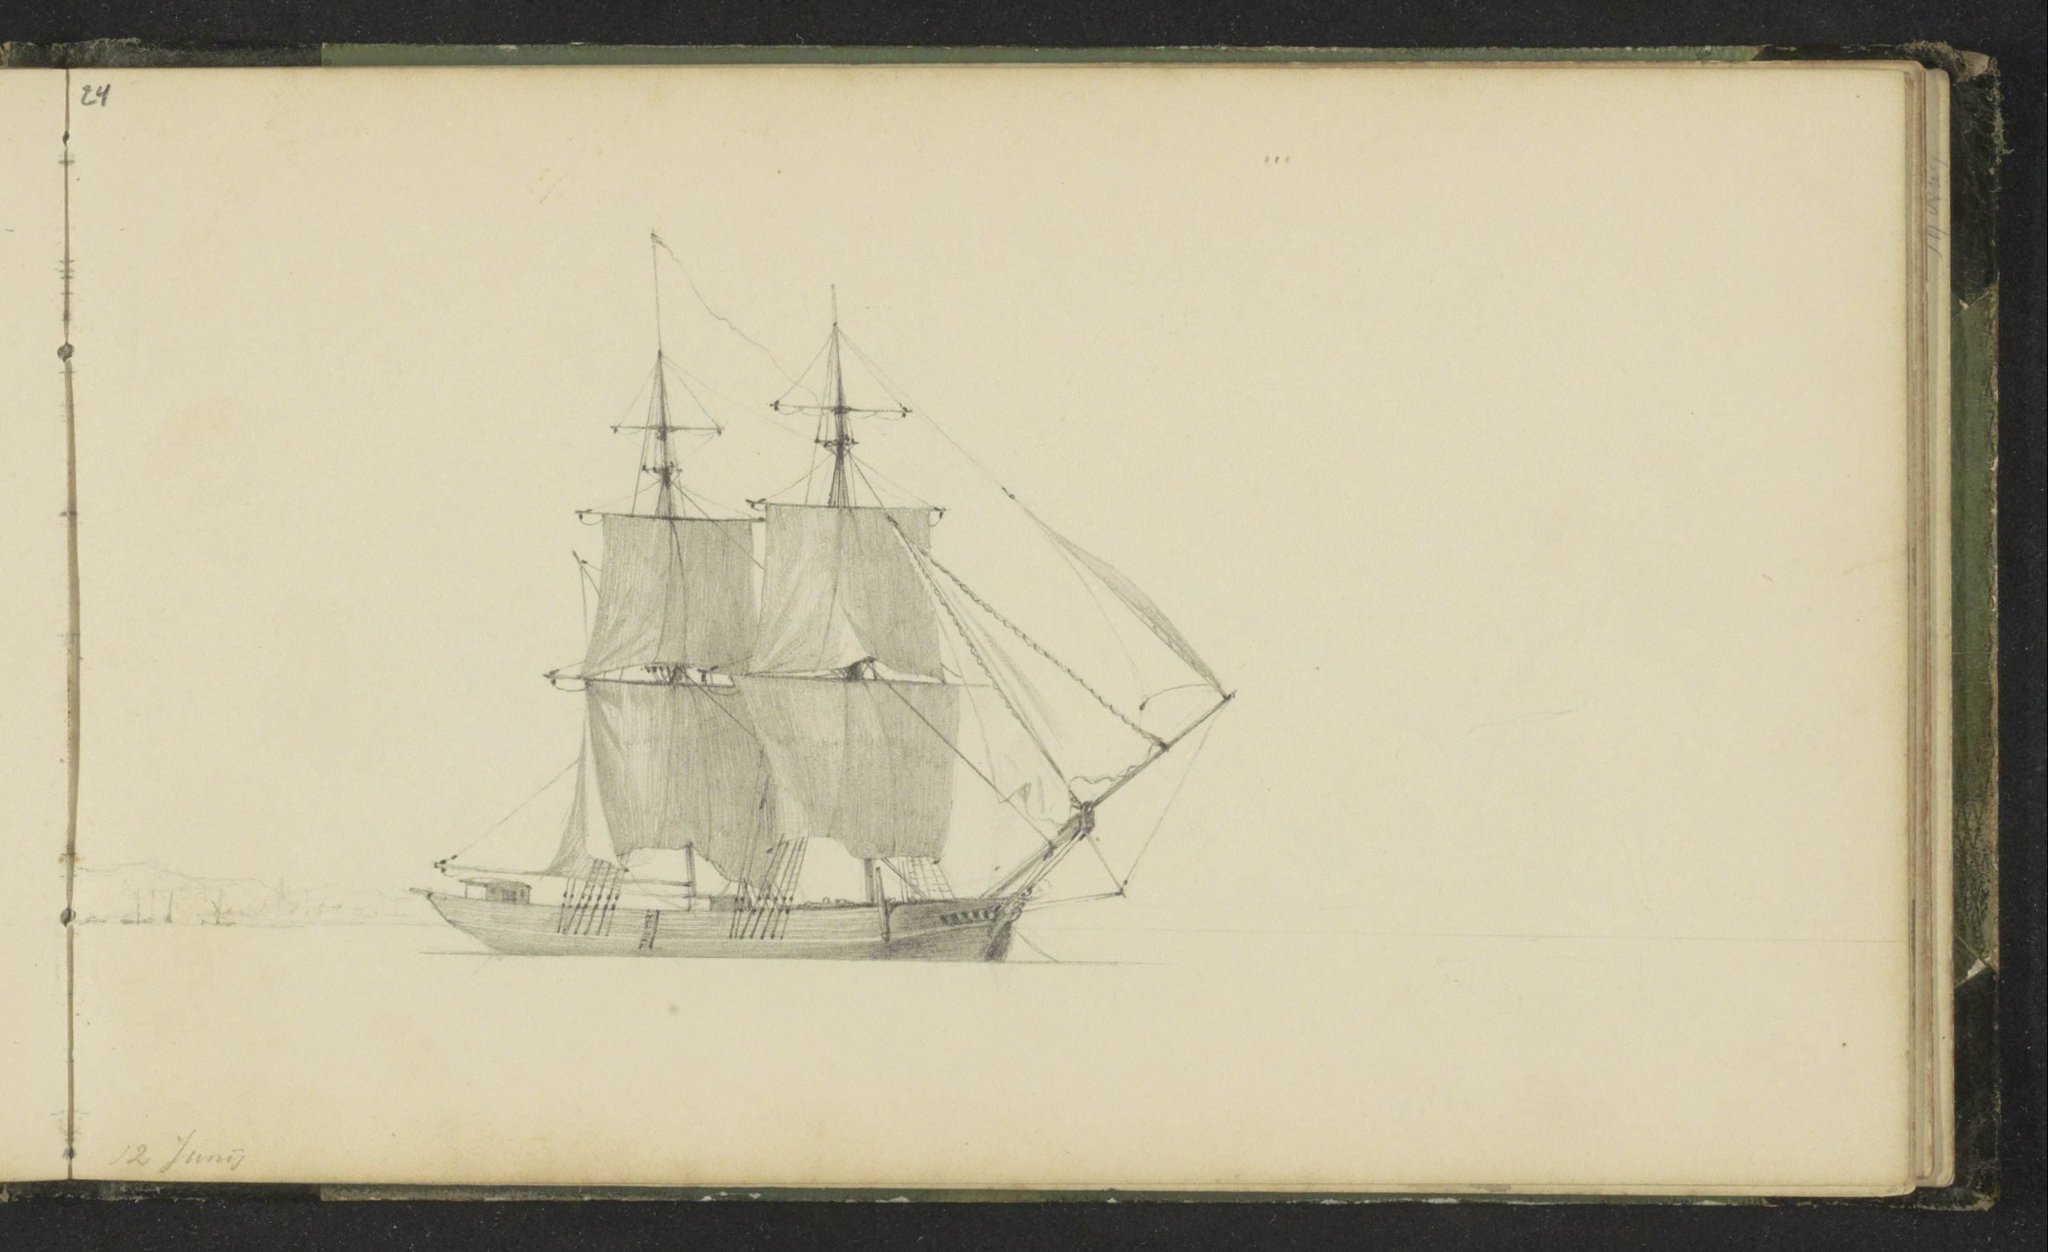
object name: sketchbook leaf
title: Afgemeerde tweemaster voor een kust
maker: hendrik abraham klinkhamer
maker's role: draughtsman, painter, print maker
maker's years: 1810-1872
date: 1806-1843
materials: paper, pencil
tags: sailing-ship, sailing-boat, coast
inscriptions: date: ‘12 Junij’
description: Blad 24 recto uit een schetsboek met 40 bladen.